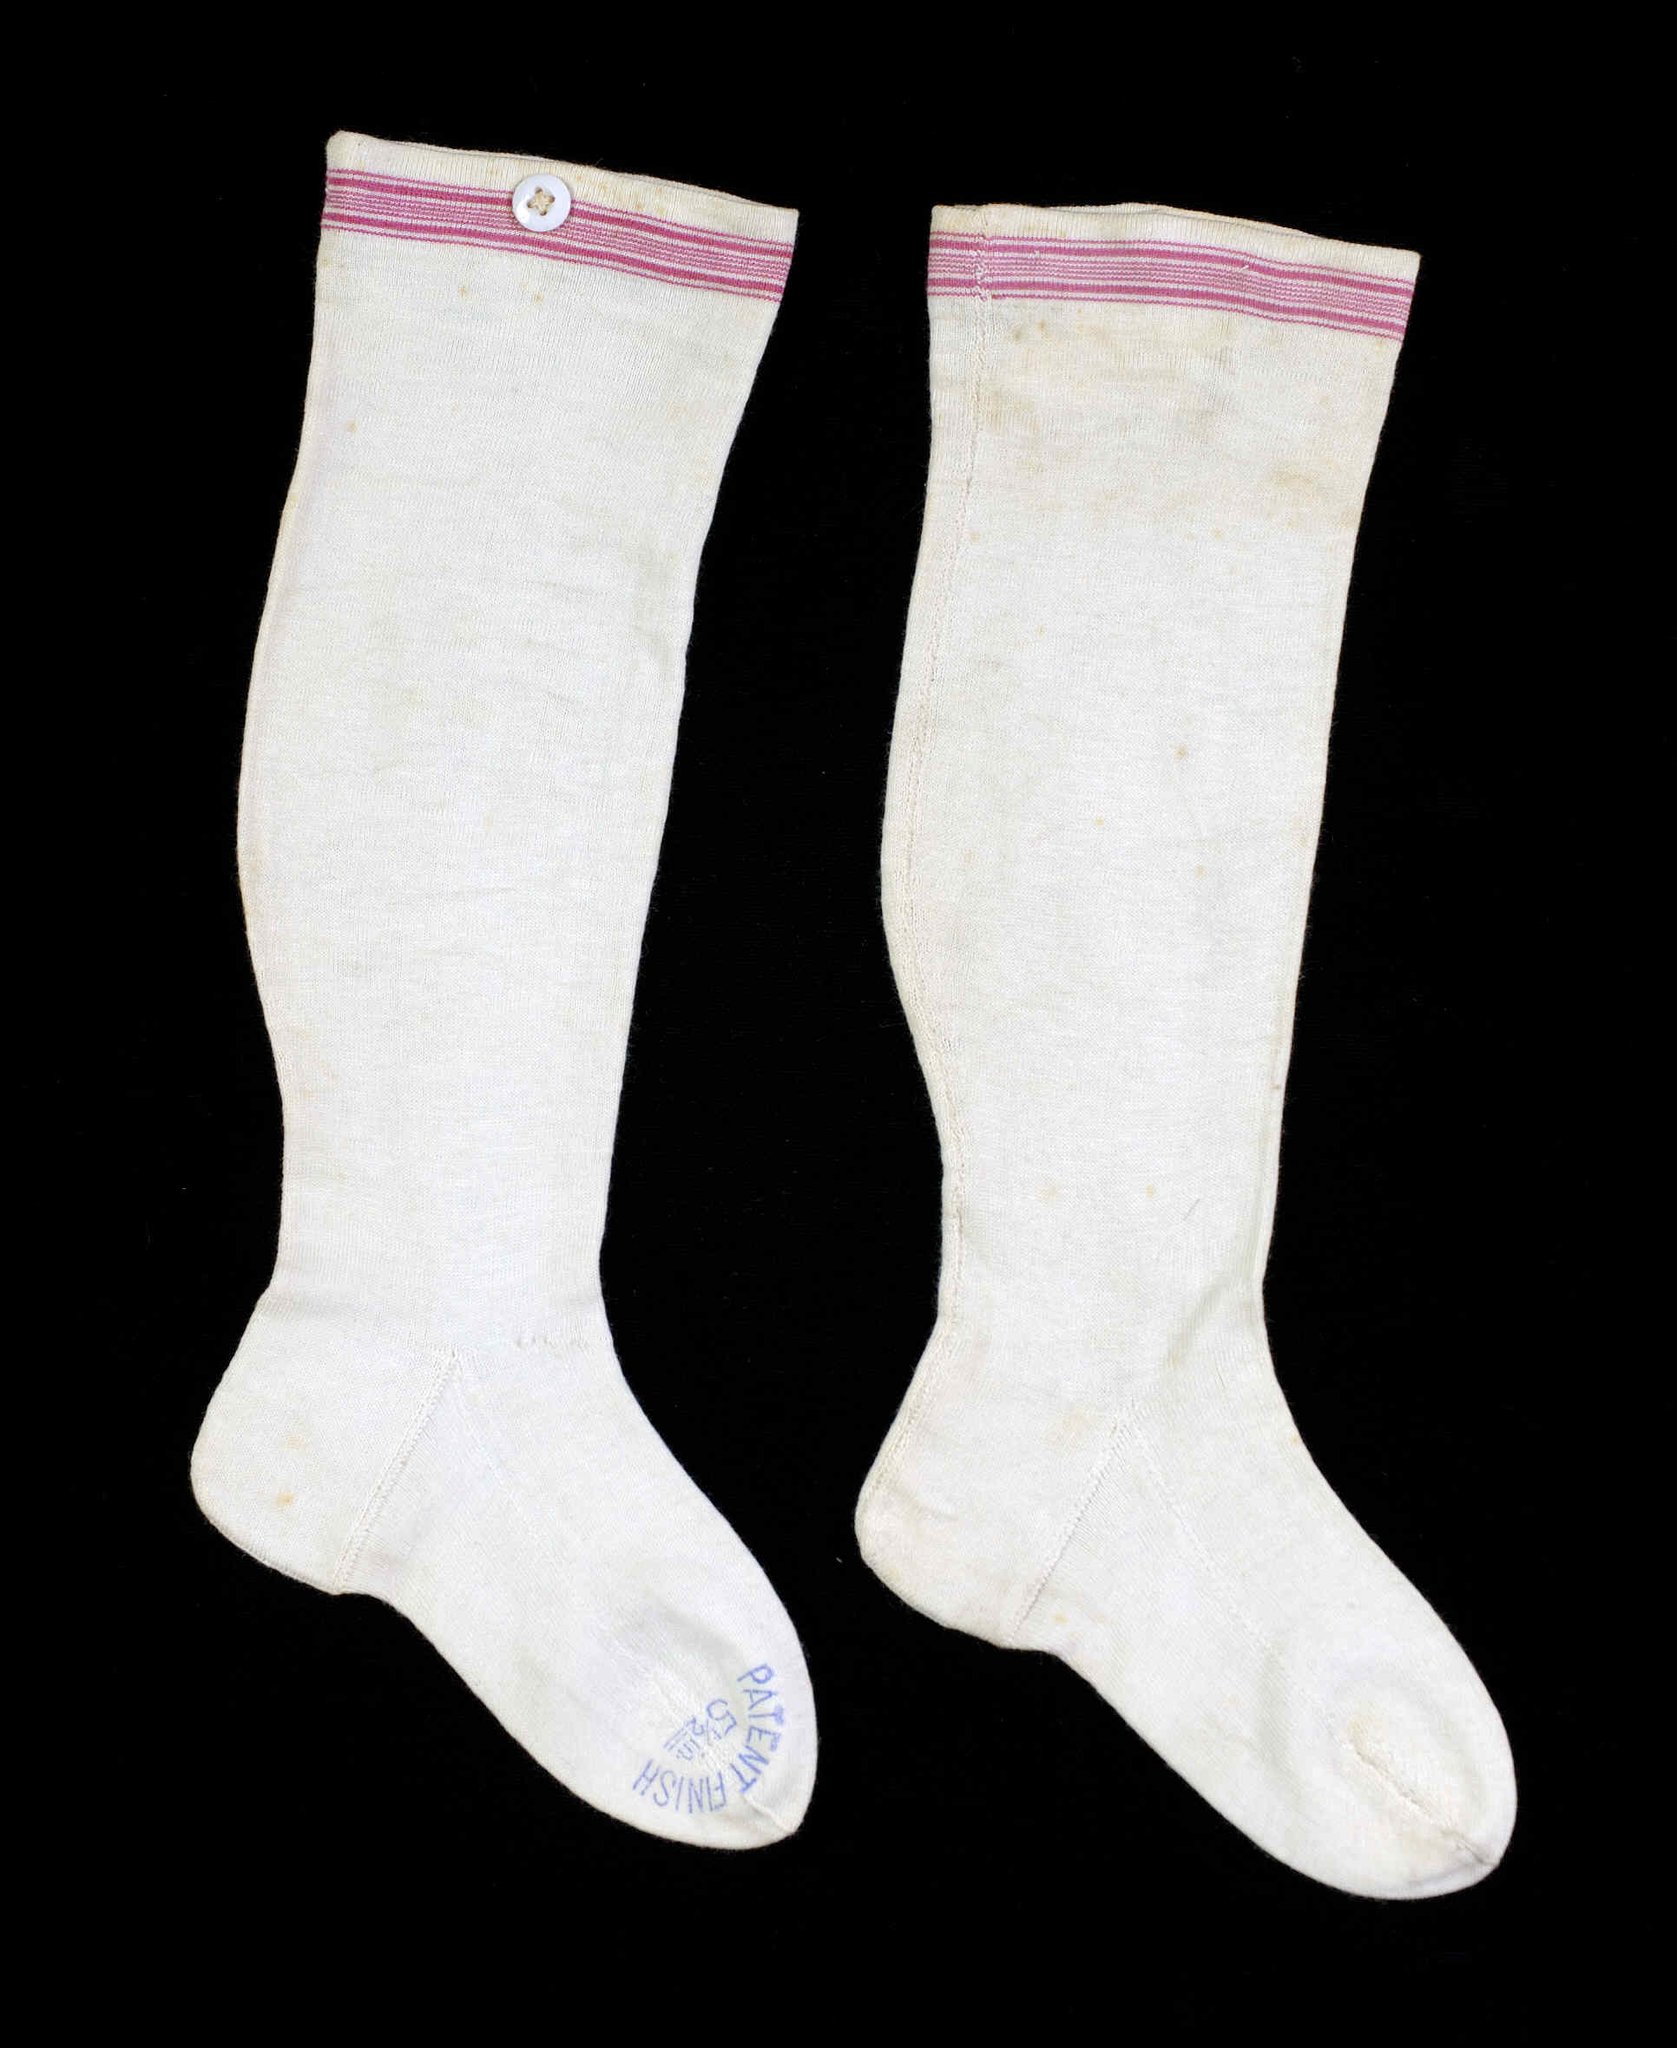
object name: stocking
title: Stockings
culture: american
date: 1876-1900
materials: cotton